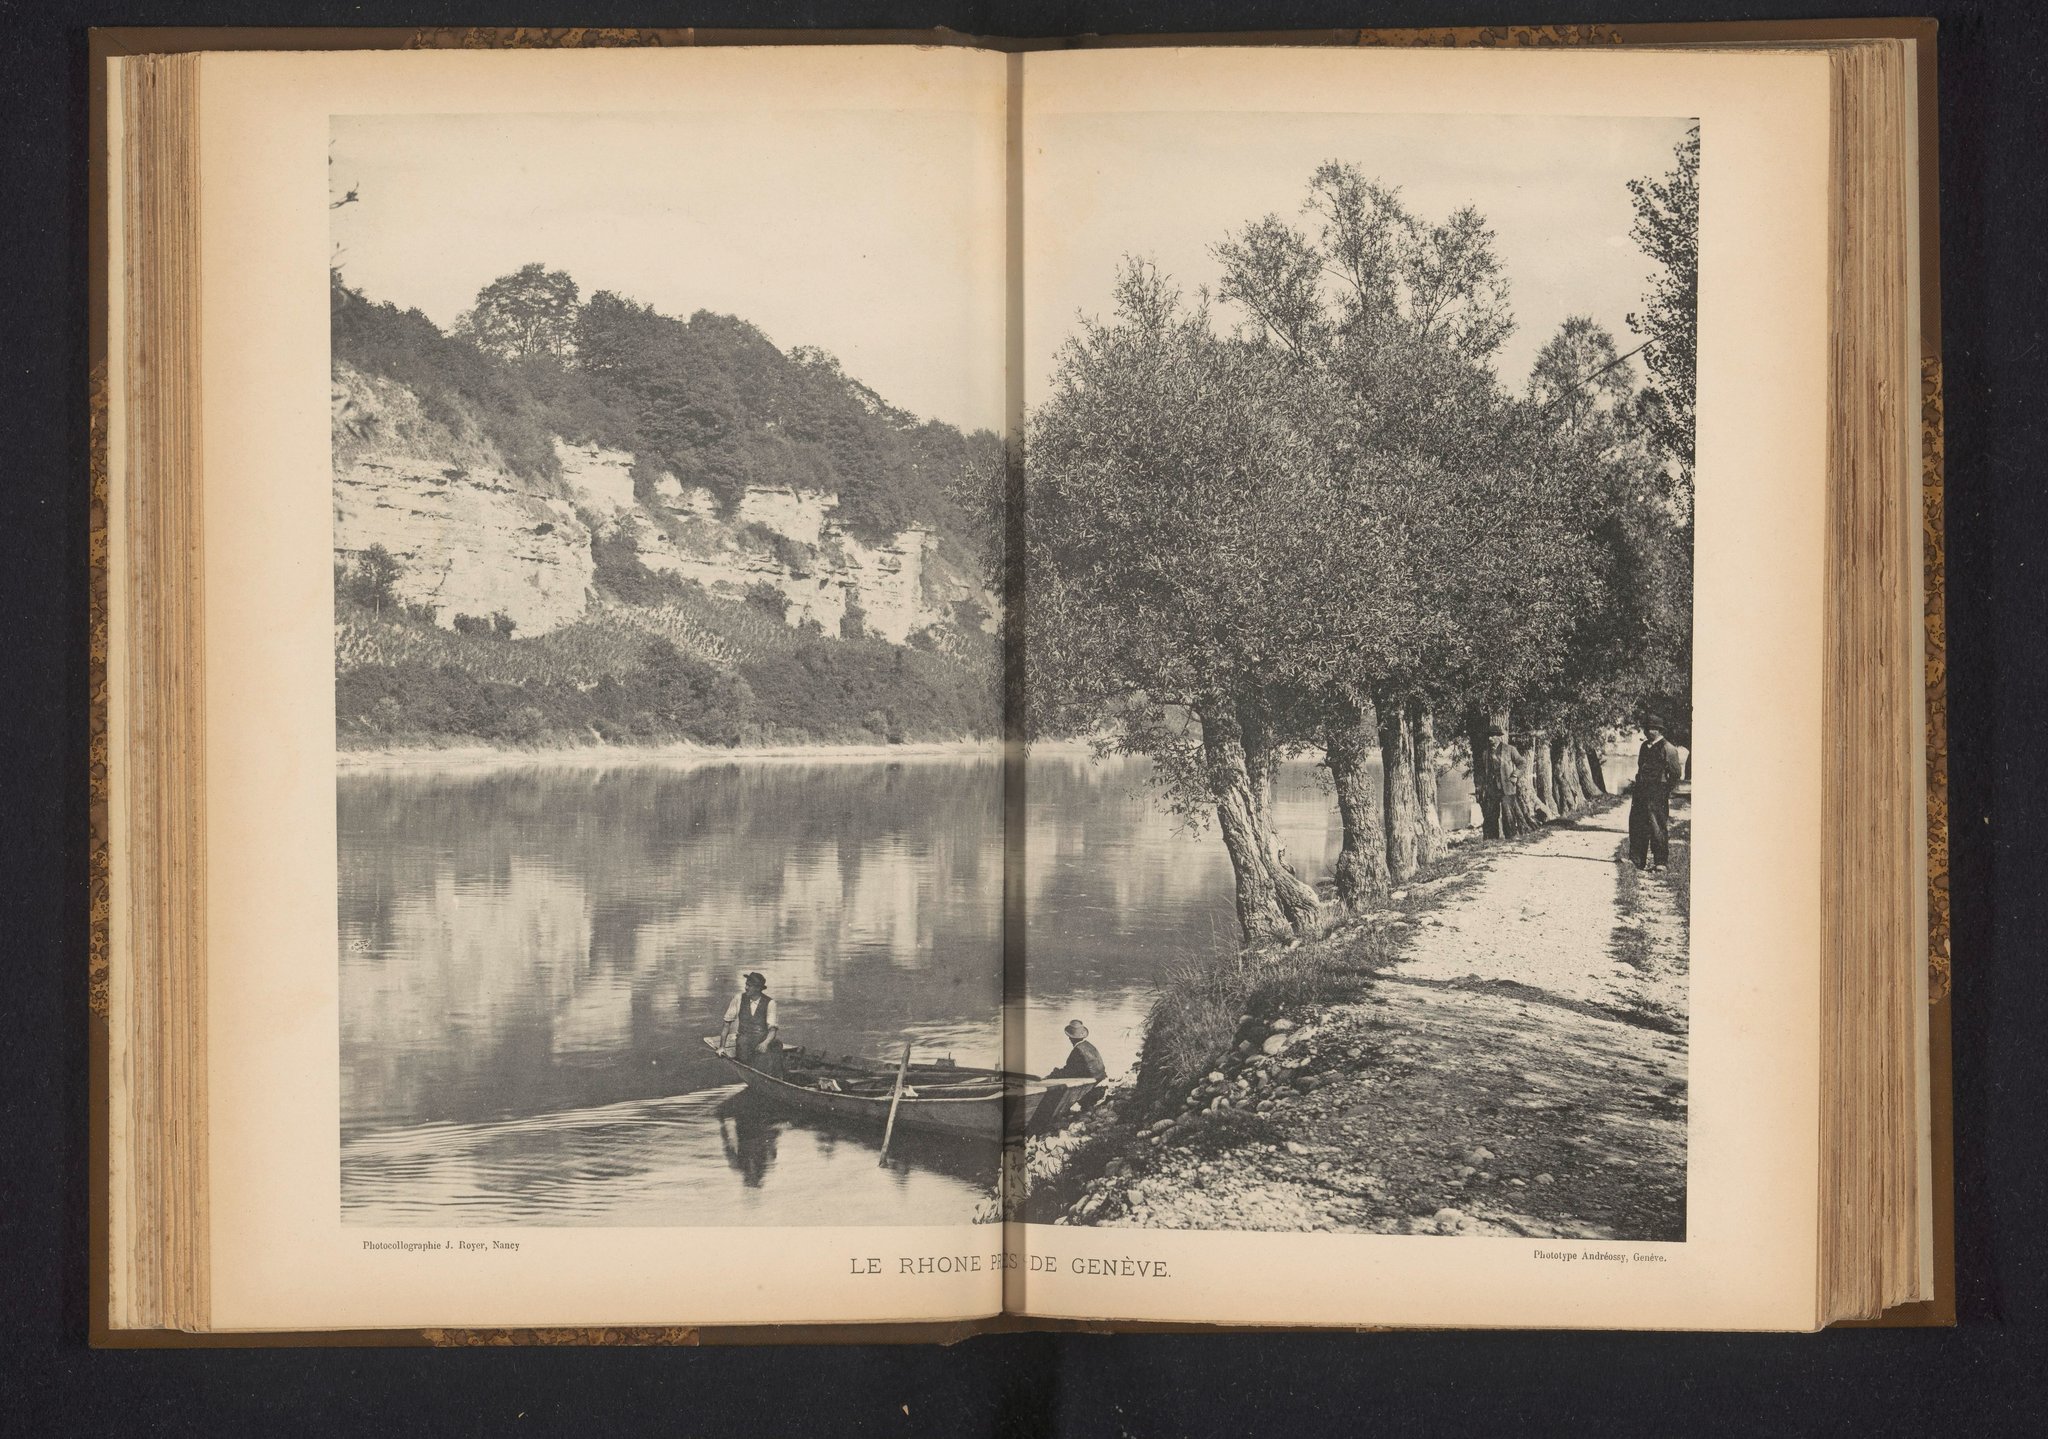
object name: photomechanical print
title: Le Rone près de Genève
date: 1888-1893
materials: paper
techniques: photograph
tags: trees, river, adult man, rowing-boat, canoe, etc., road, path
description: Prent op tweede en derde pagina na pagina 116.